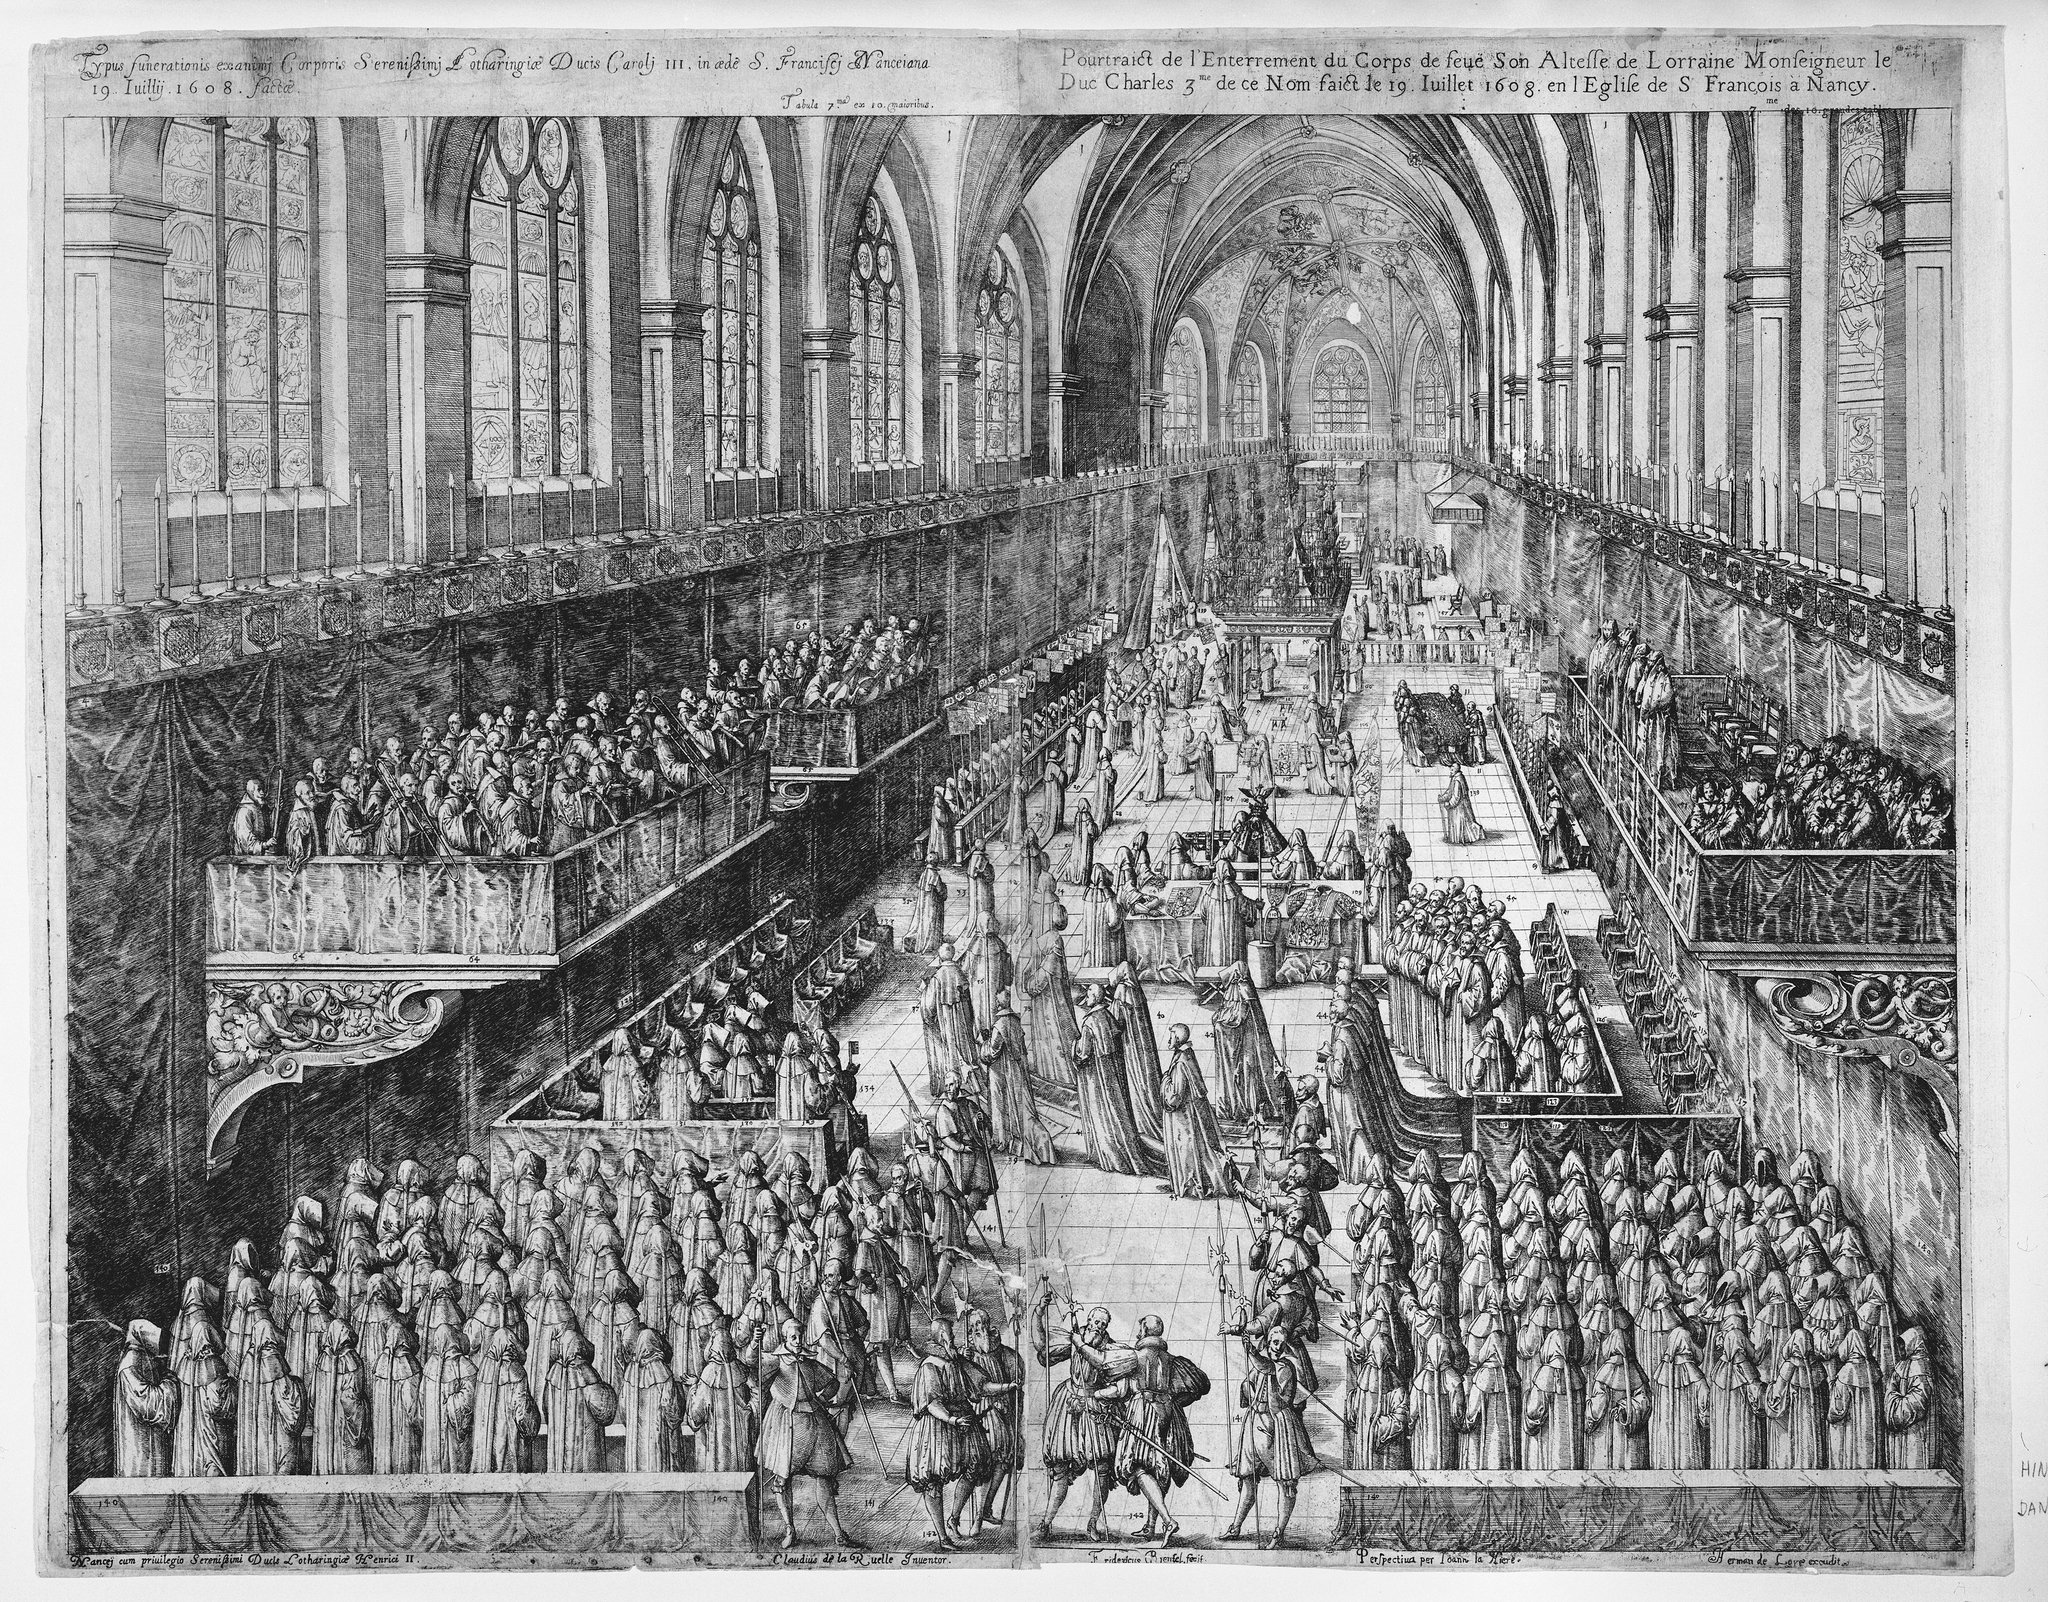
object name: book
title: Part I: Carolo III. Lotharingiae et Barri Duci. . .Dix grande Tables, contenantes les pourtaictz des pompe funebres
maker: frédéric brentel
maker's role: artist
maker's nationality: german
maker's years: 1580-1651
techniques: engraving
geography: france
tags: interiors,churches,ceremony,crowd